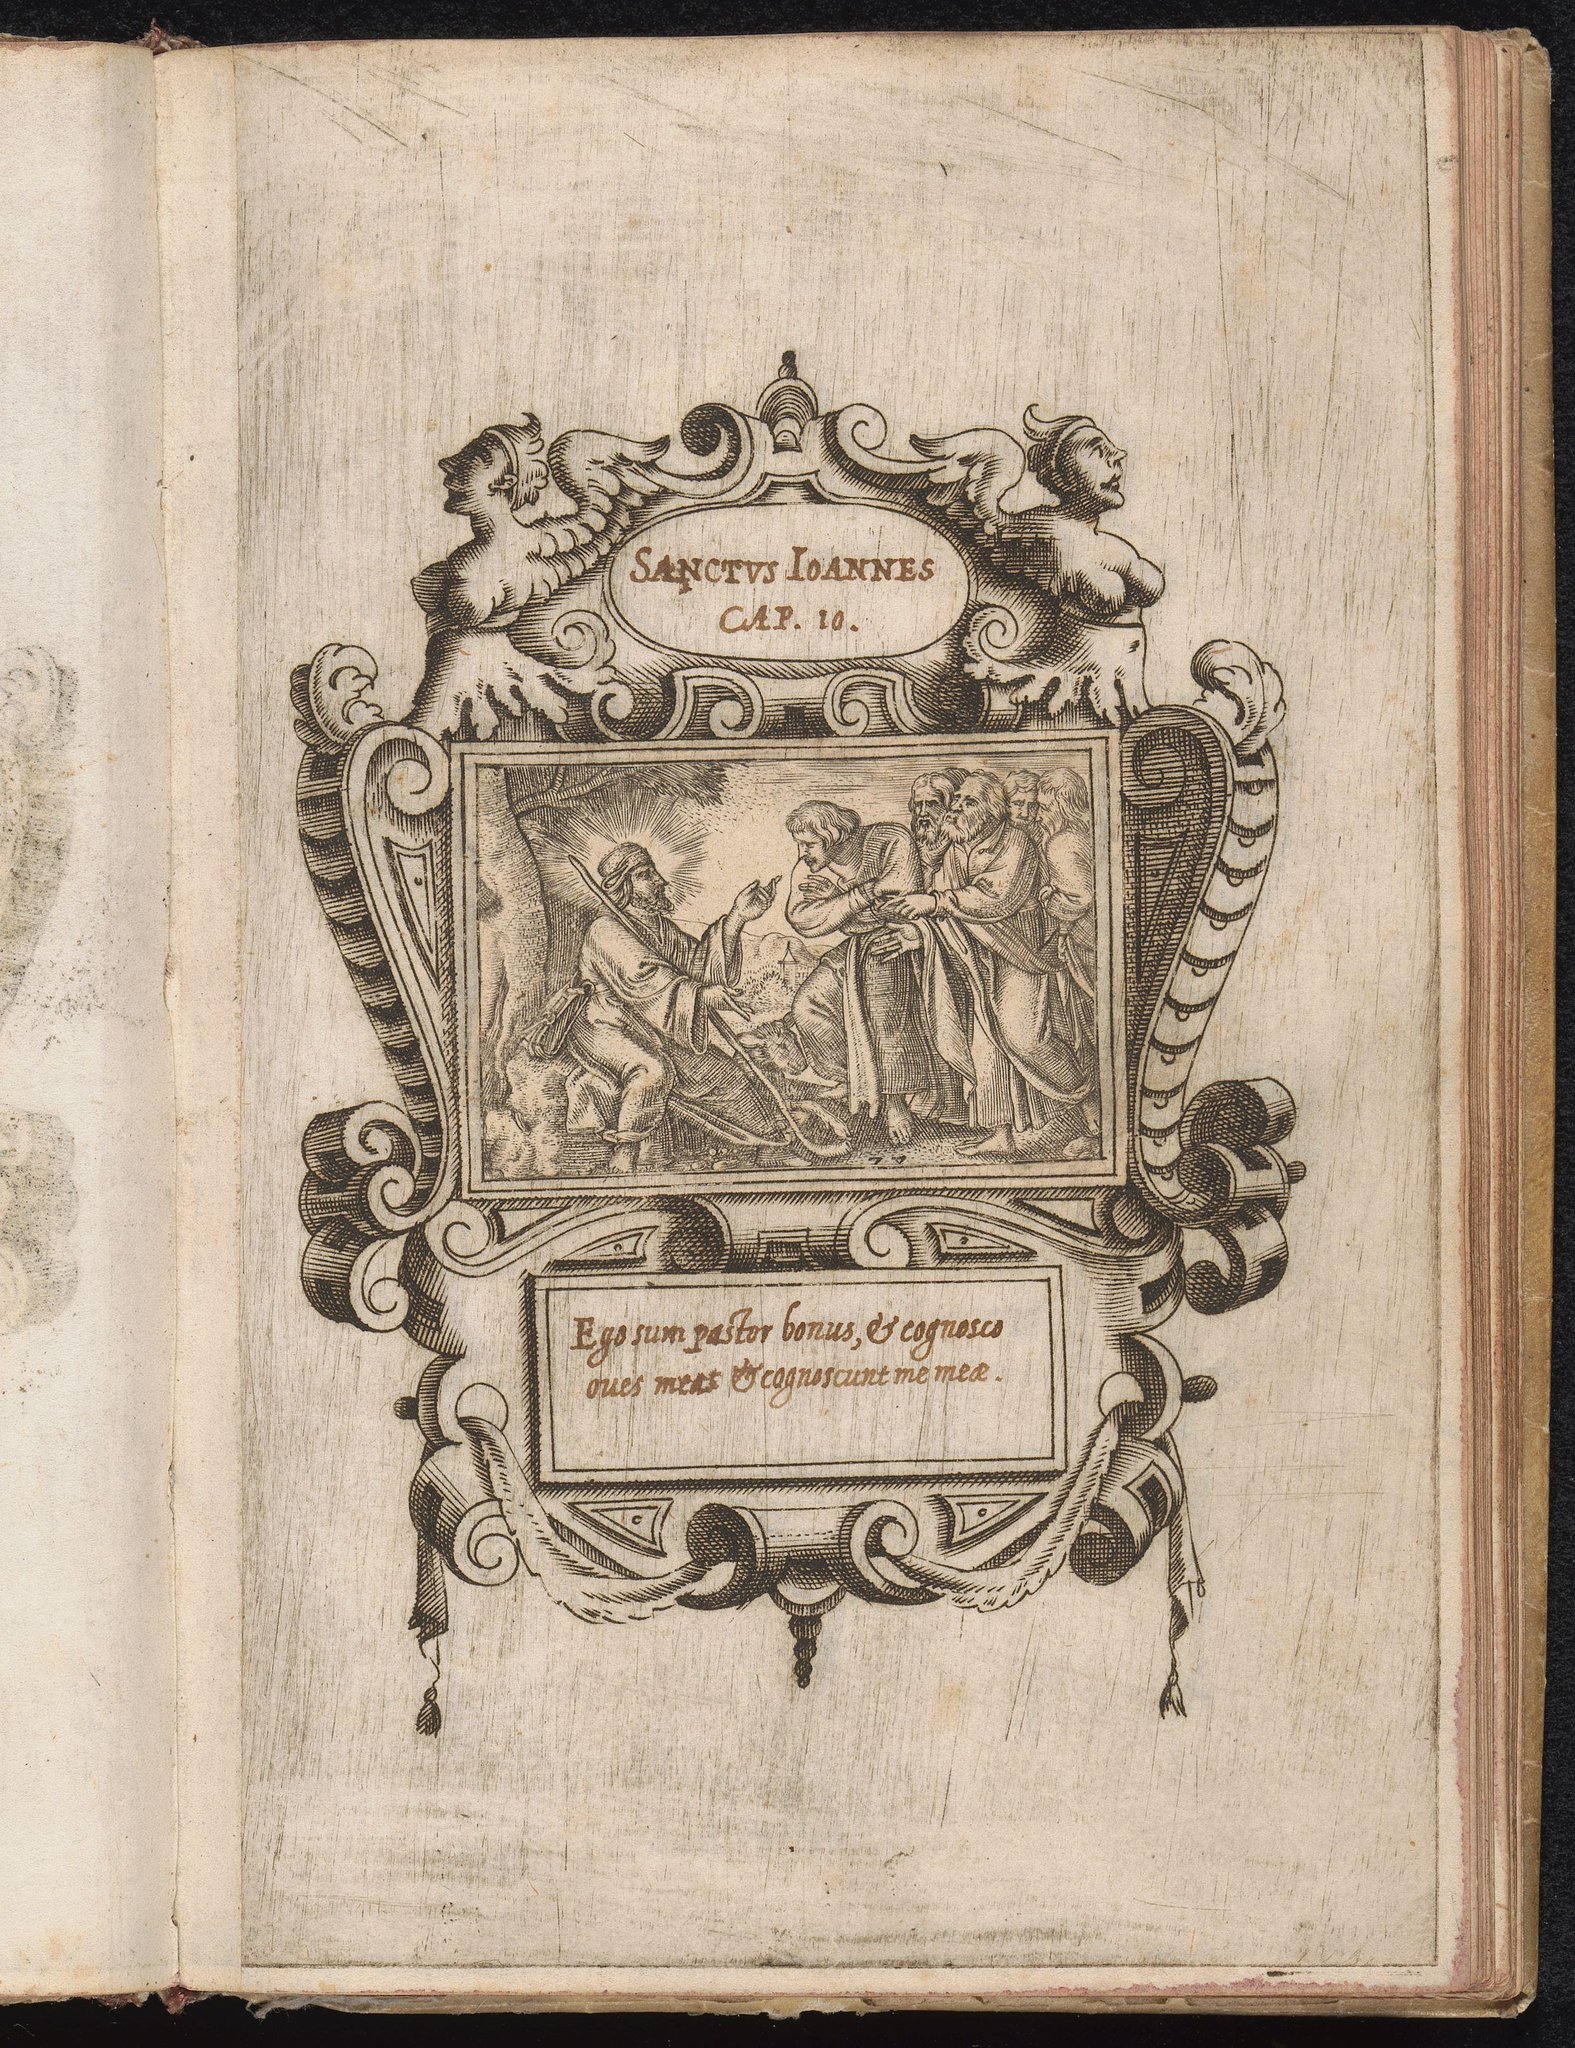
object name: print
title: Christus spreekt met de discipelen over de Goede Herder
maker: Anonymous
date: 1570-1610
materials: paper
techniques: engraving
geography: antwerp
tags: the lost sheep sought and found by the shepherd ~ parable of the good shepherd (matthew 18:12-14; luke 15:4-7)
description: Christus spreekt met de discipelen over de Goede Herder. Onderdeel van een prentalbum met titelprent en 56 scènes uit het Nieuwe Testament. Elke voorstelling gemonteerd in een gravure met ornamentele cartouches waarin een venster is gesneden en voorzien van handgeschreven bijbelpassages.